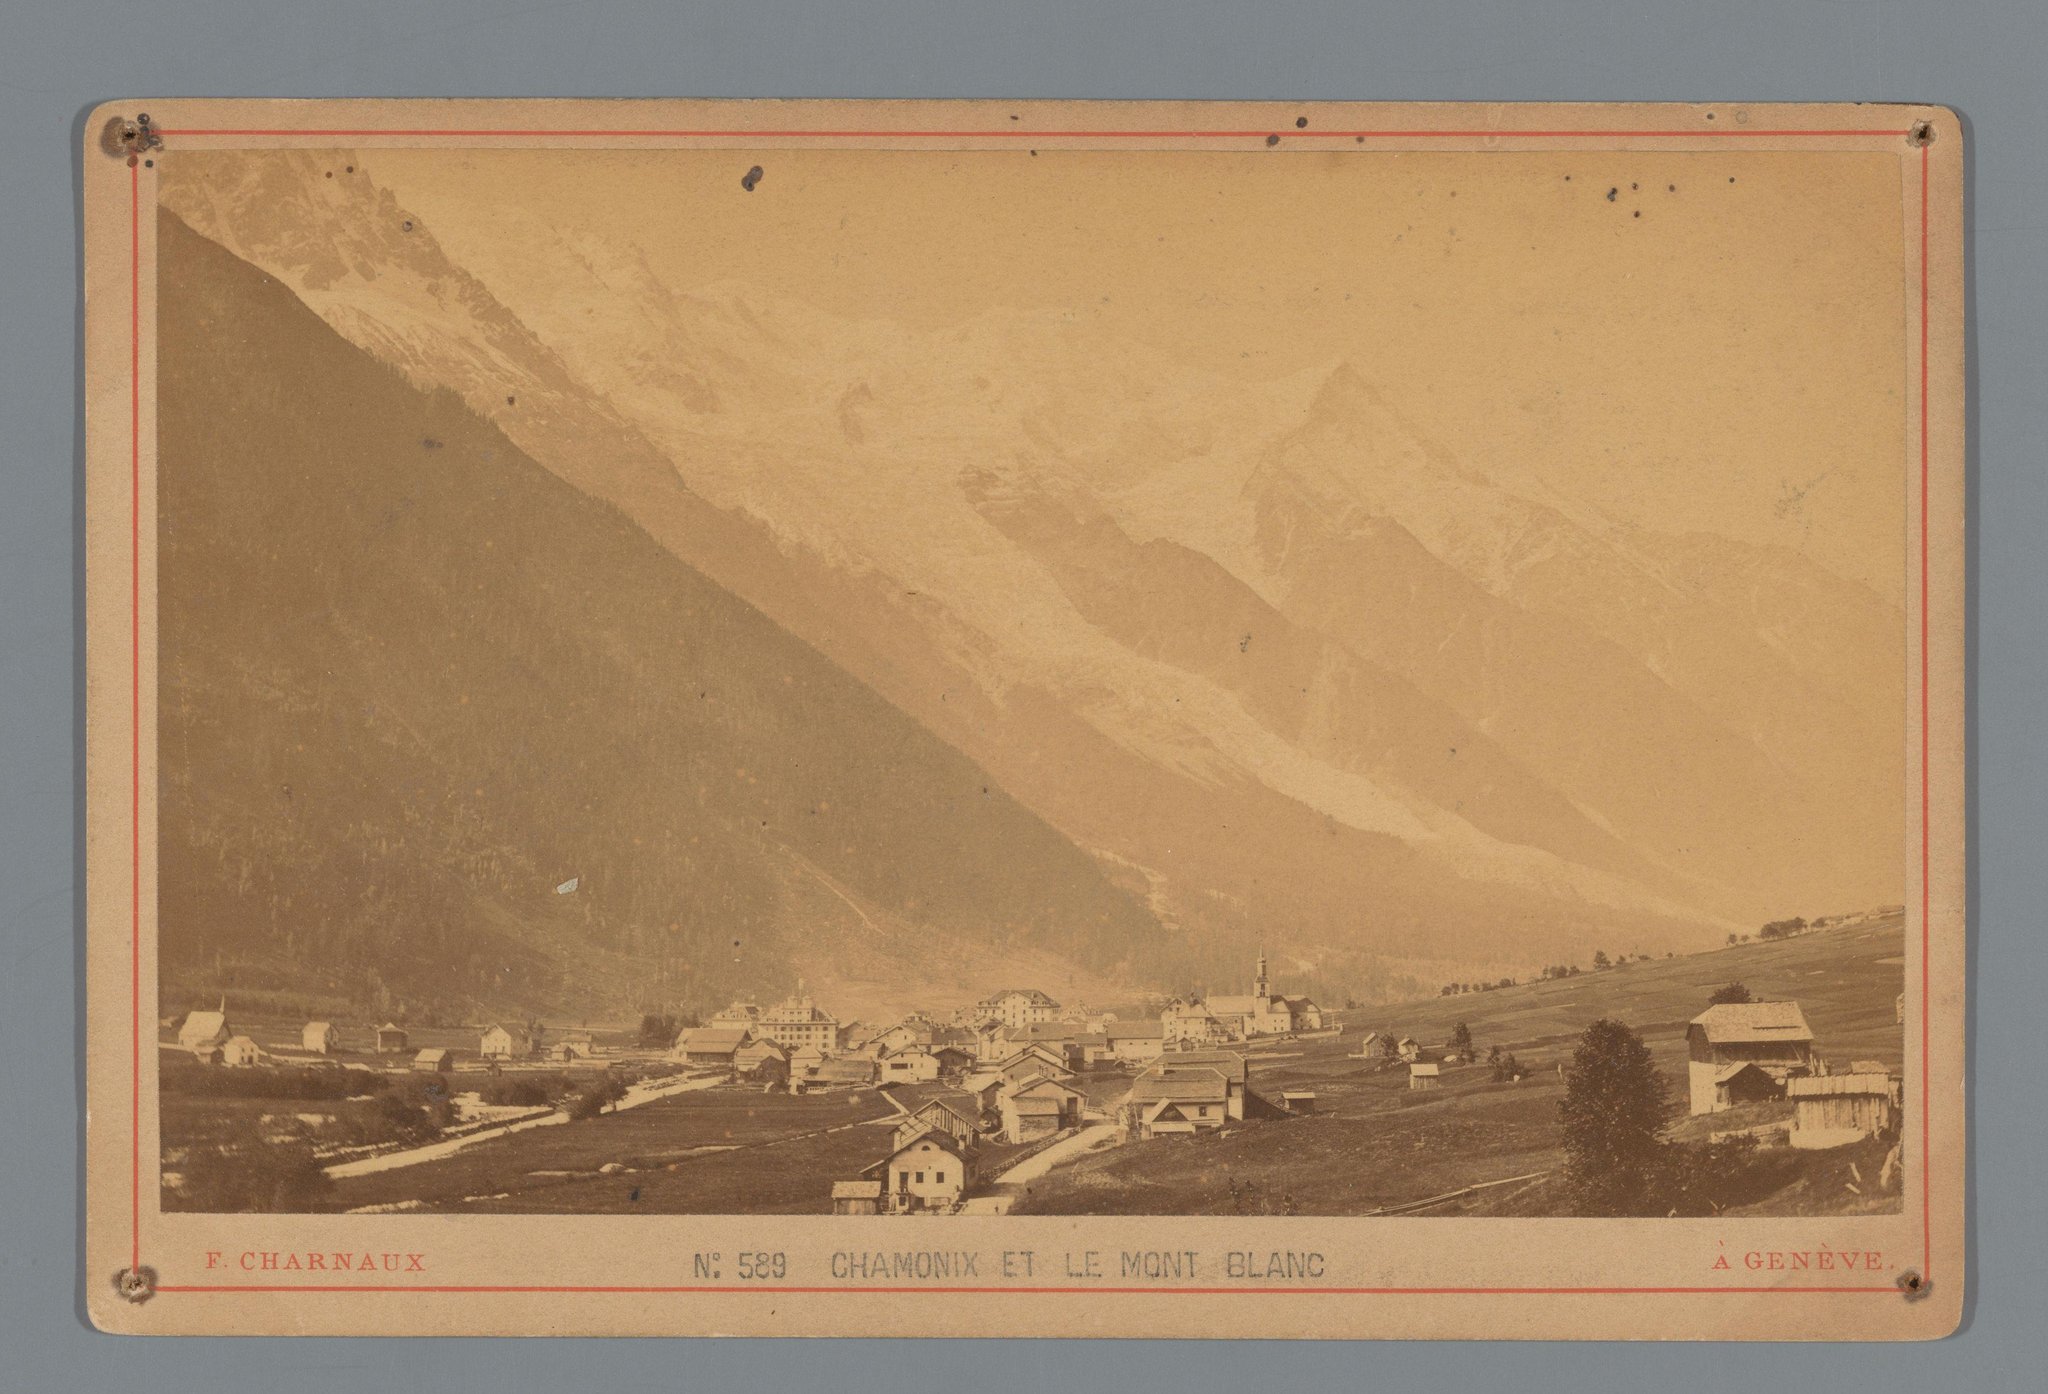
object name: photograph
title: Gezicht op Chamonix met bergen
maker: florentin charnaux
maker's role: publisher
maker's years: 1819-1883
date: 1870-1900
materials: cardboard, photographic support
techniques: albumen print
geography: chamonix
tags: city-view in general; 'veduta', mountains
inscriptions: inscription: ‘A Geneve’, number: ‘N. 589’, workshop stamp: ‘Maison des trois rois/ PARIS 1870/ LYON 1872/ VIENNE 1873’